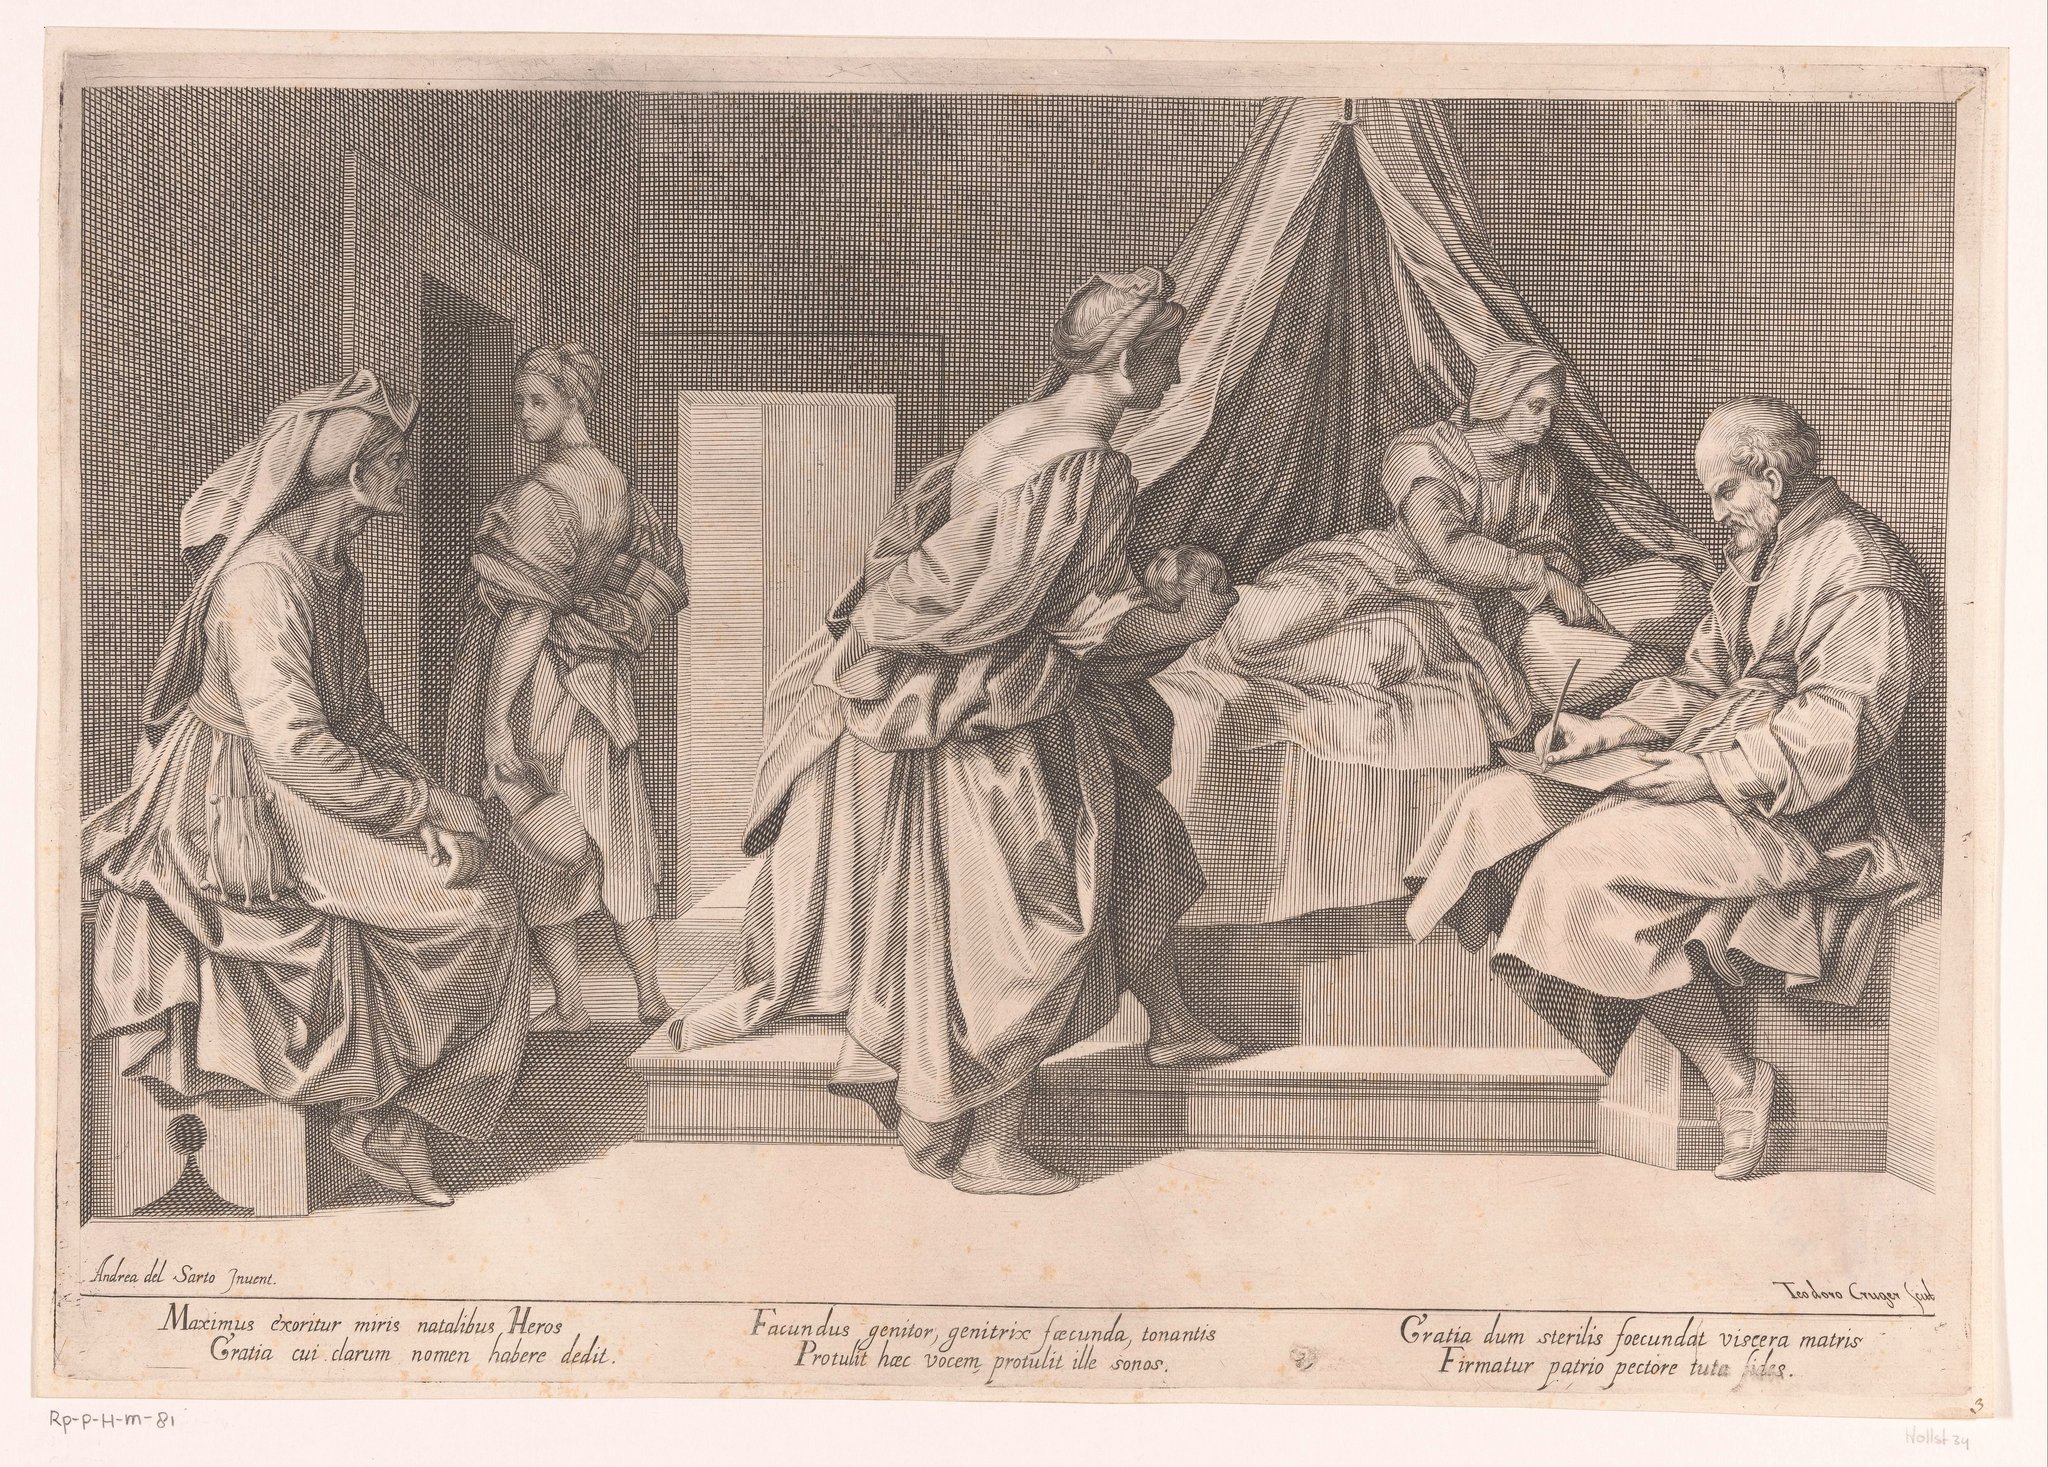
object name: print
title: Johannes de Doper wordt geboren en ontvangt zijn naam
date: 1617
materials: paper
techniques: engraving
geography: florence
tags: birth of john the baptist, sometimes mary present, naming of john the baptist; zacharias writing john's name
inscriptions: collector's mark: Lugt 11, collector's mark: ‘Hinloopen’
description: Onderdeel van een serie van dertien prenten en een titelprent. Origineel onderdeel geweest van het album Schijnvoet-nummer 24.